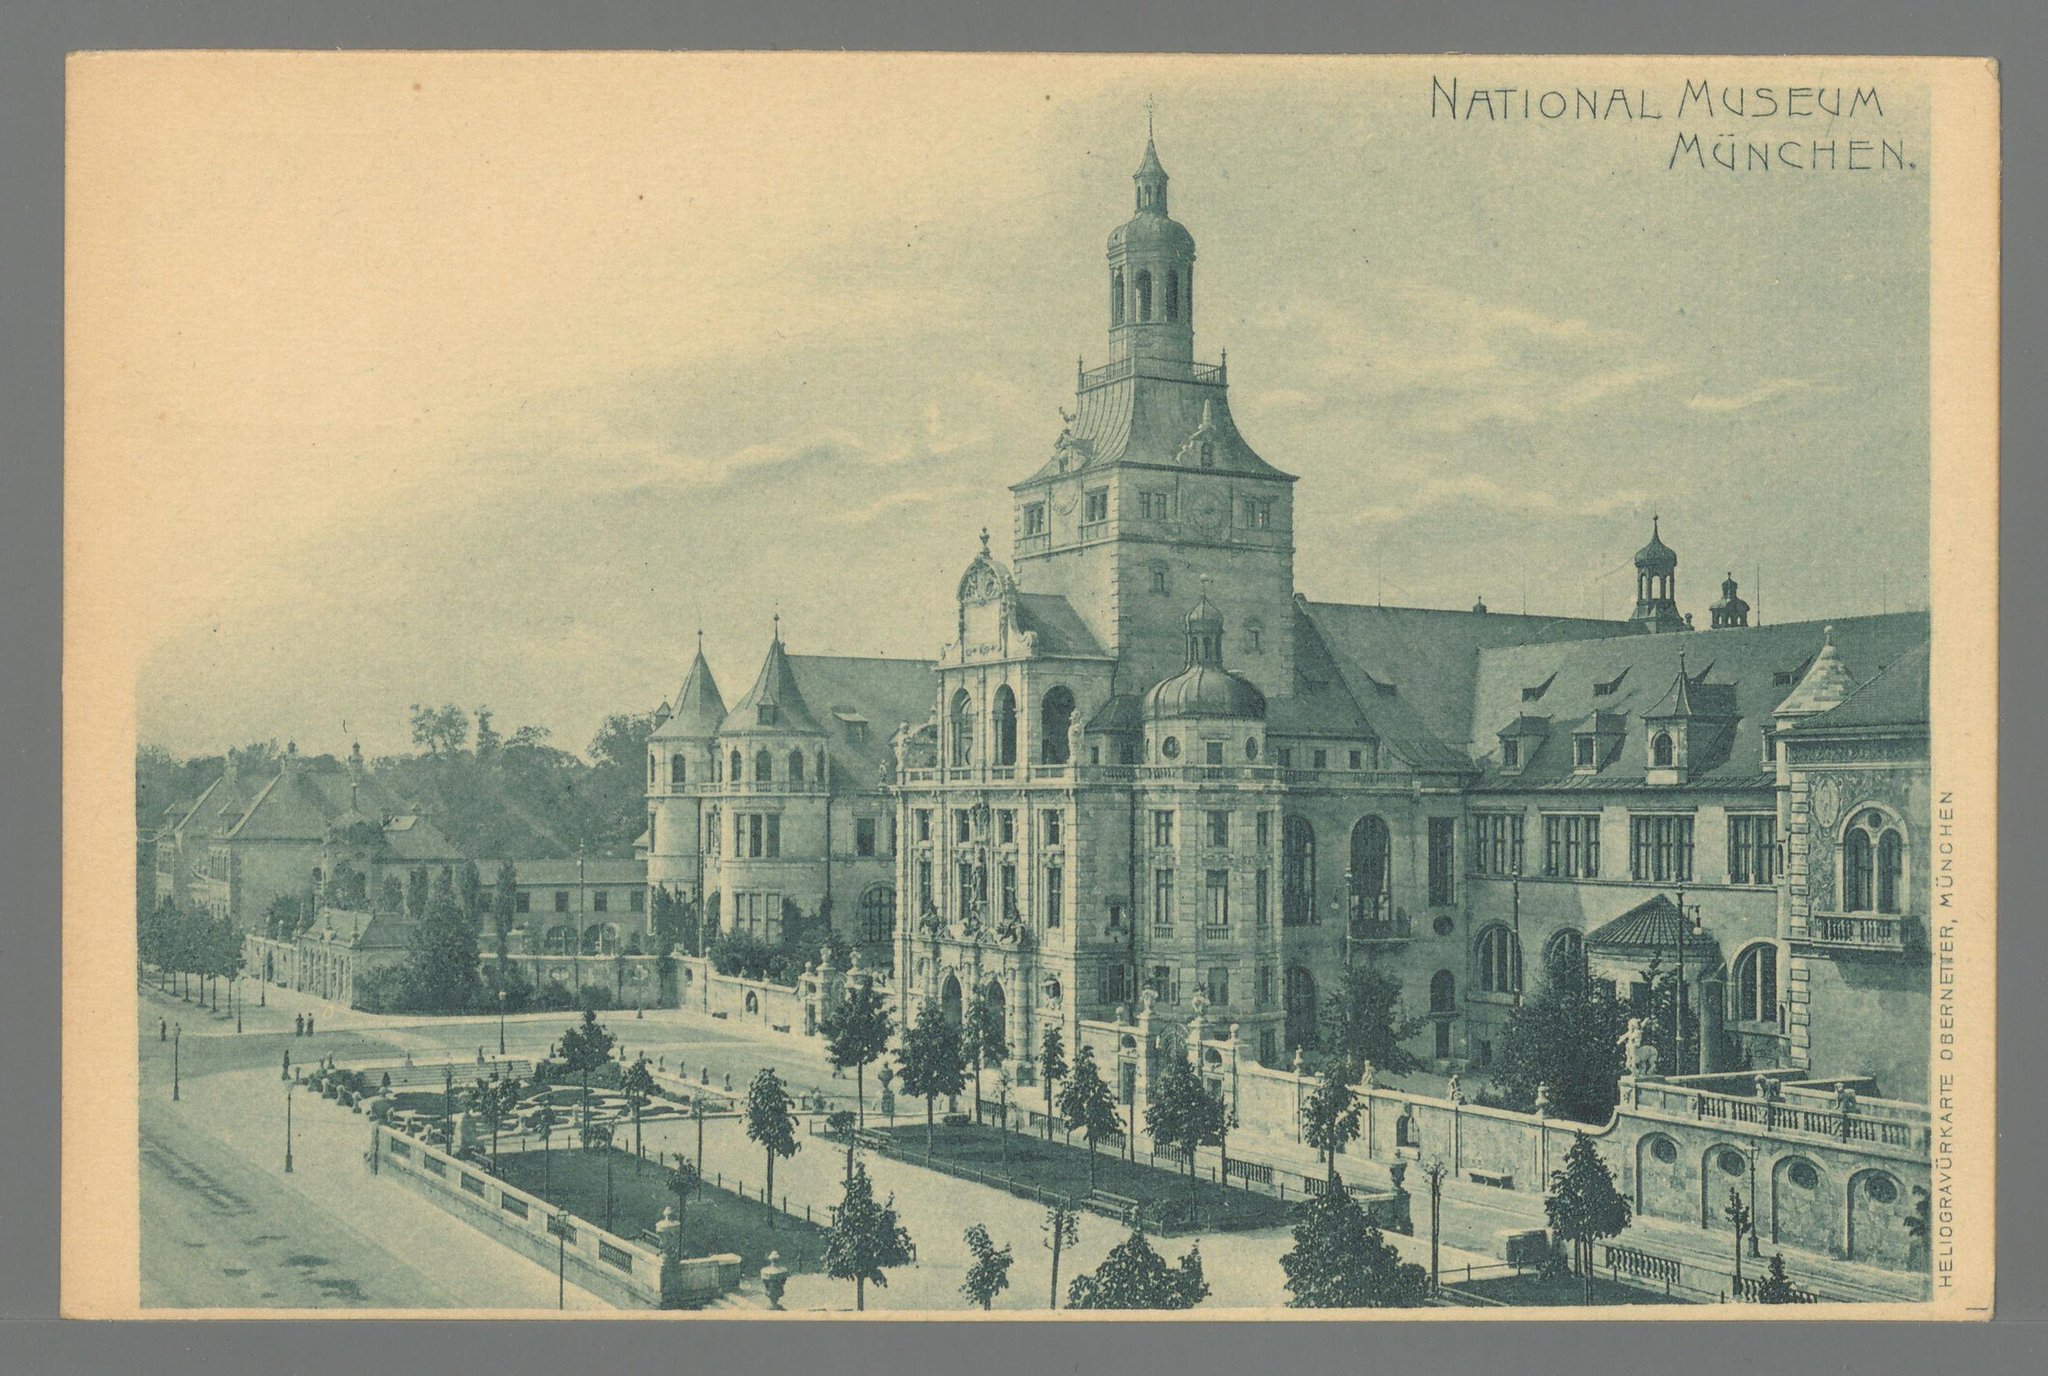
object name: photomechanical print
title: National Museum München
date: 1885-1905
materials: cardboard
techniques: photoaquatint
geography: munich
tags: permanent exhibition, museum